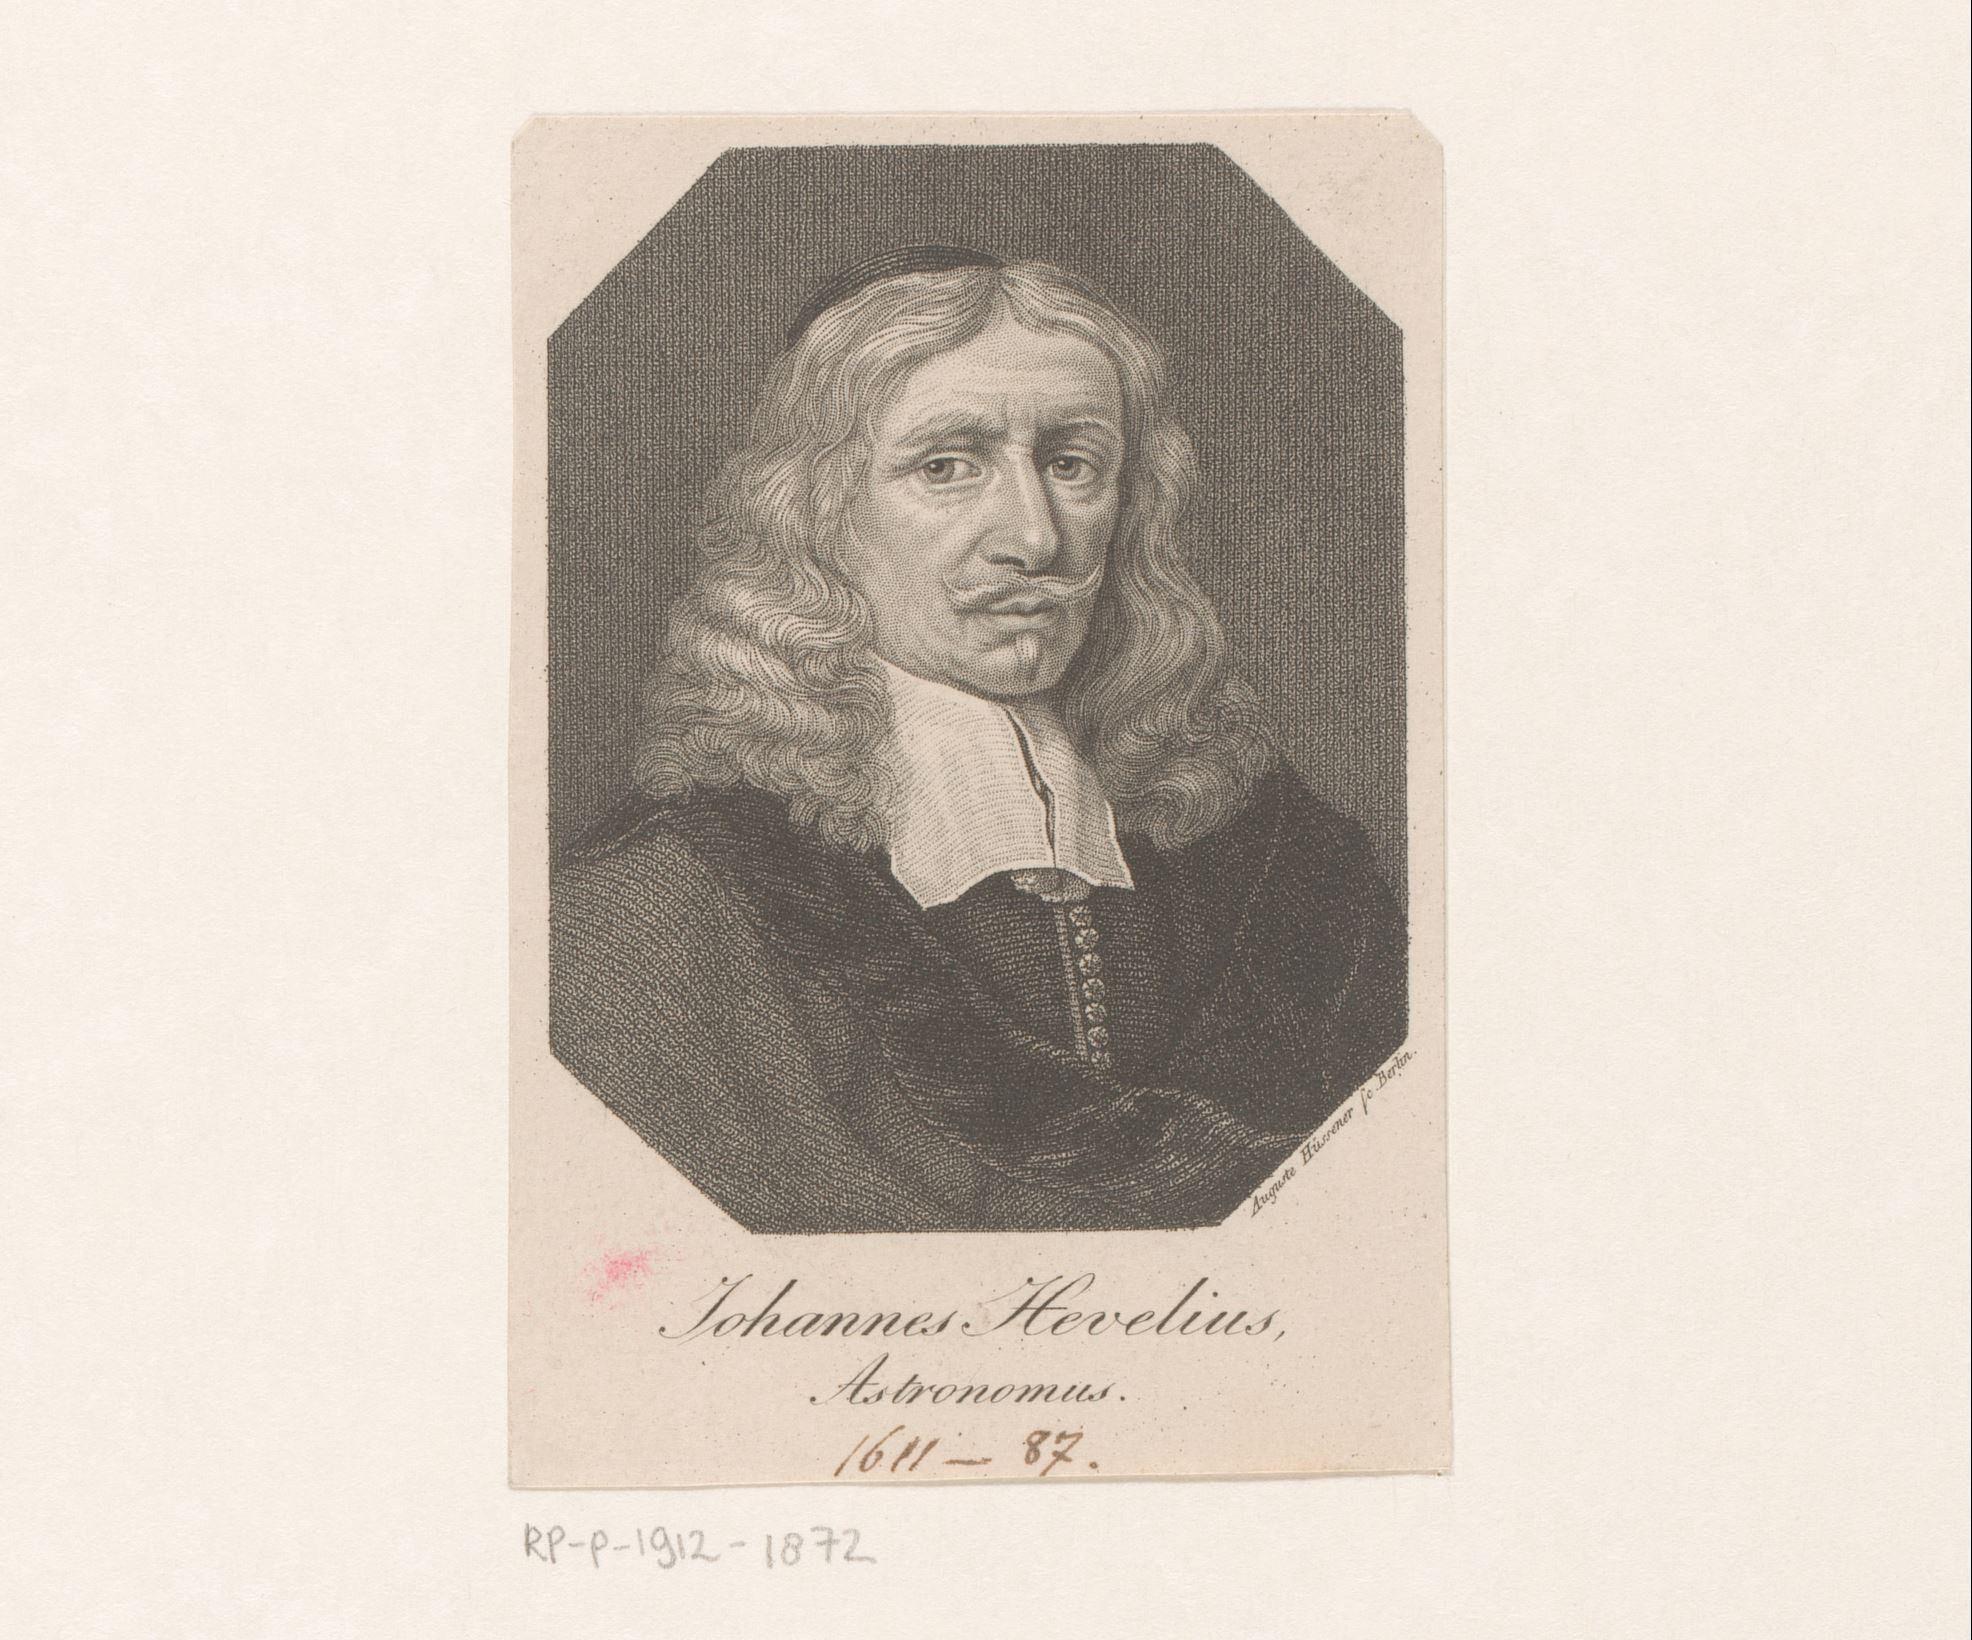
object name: print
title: Portret van Johannes Hevelius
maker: auguste hüssener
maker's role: print maker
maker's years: 1789-1877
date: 1621-1877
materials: paper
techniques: stippling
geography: berlin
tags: scholar, philosopher, historical persons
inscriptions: collector's mark: Lugt 2228, annotation: ‘1611-87.’